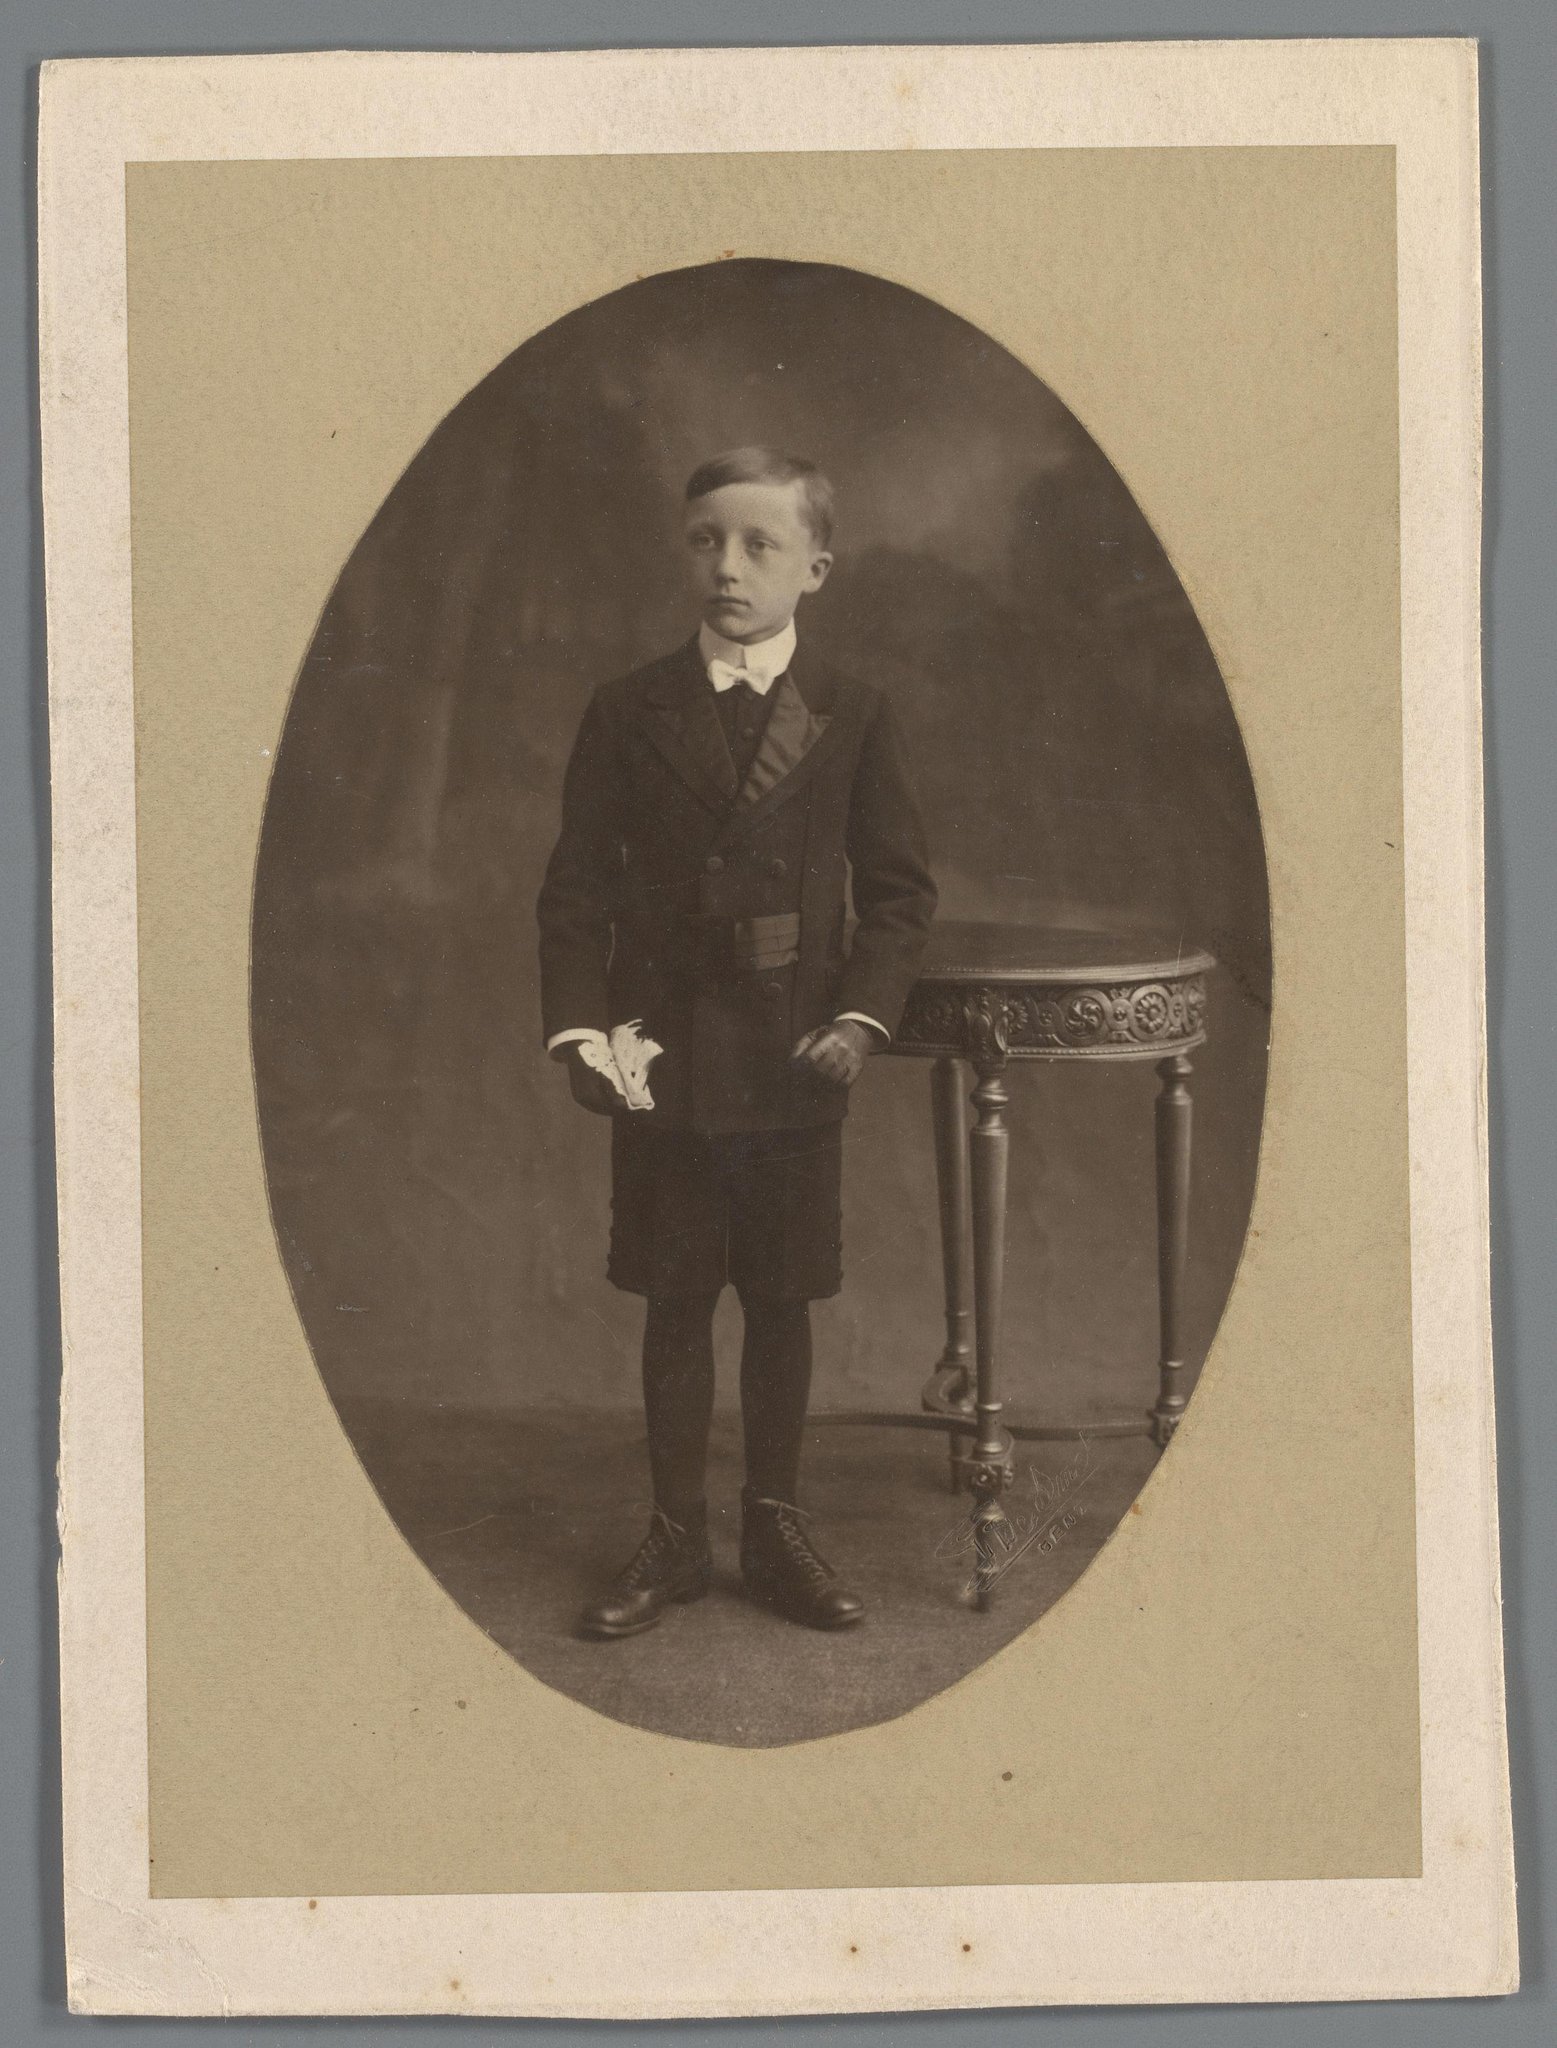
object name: photograph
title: Portret van een onbekende jongen, staande naast een tafel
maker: Anonymous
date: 1900-1920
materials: cardboard, photographic support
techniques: gelatin silver print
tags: boy (child between toddler and youth), table, anonymous historical person portrayed